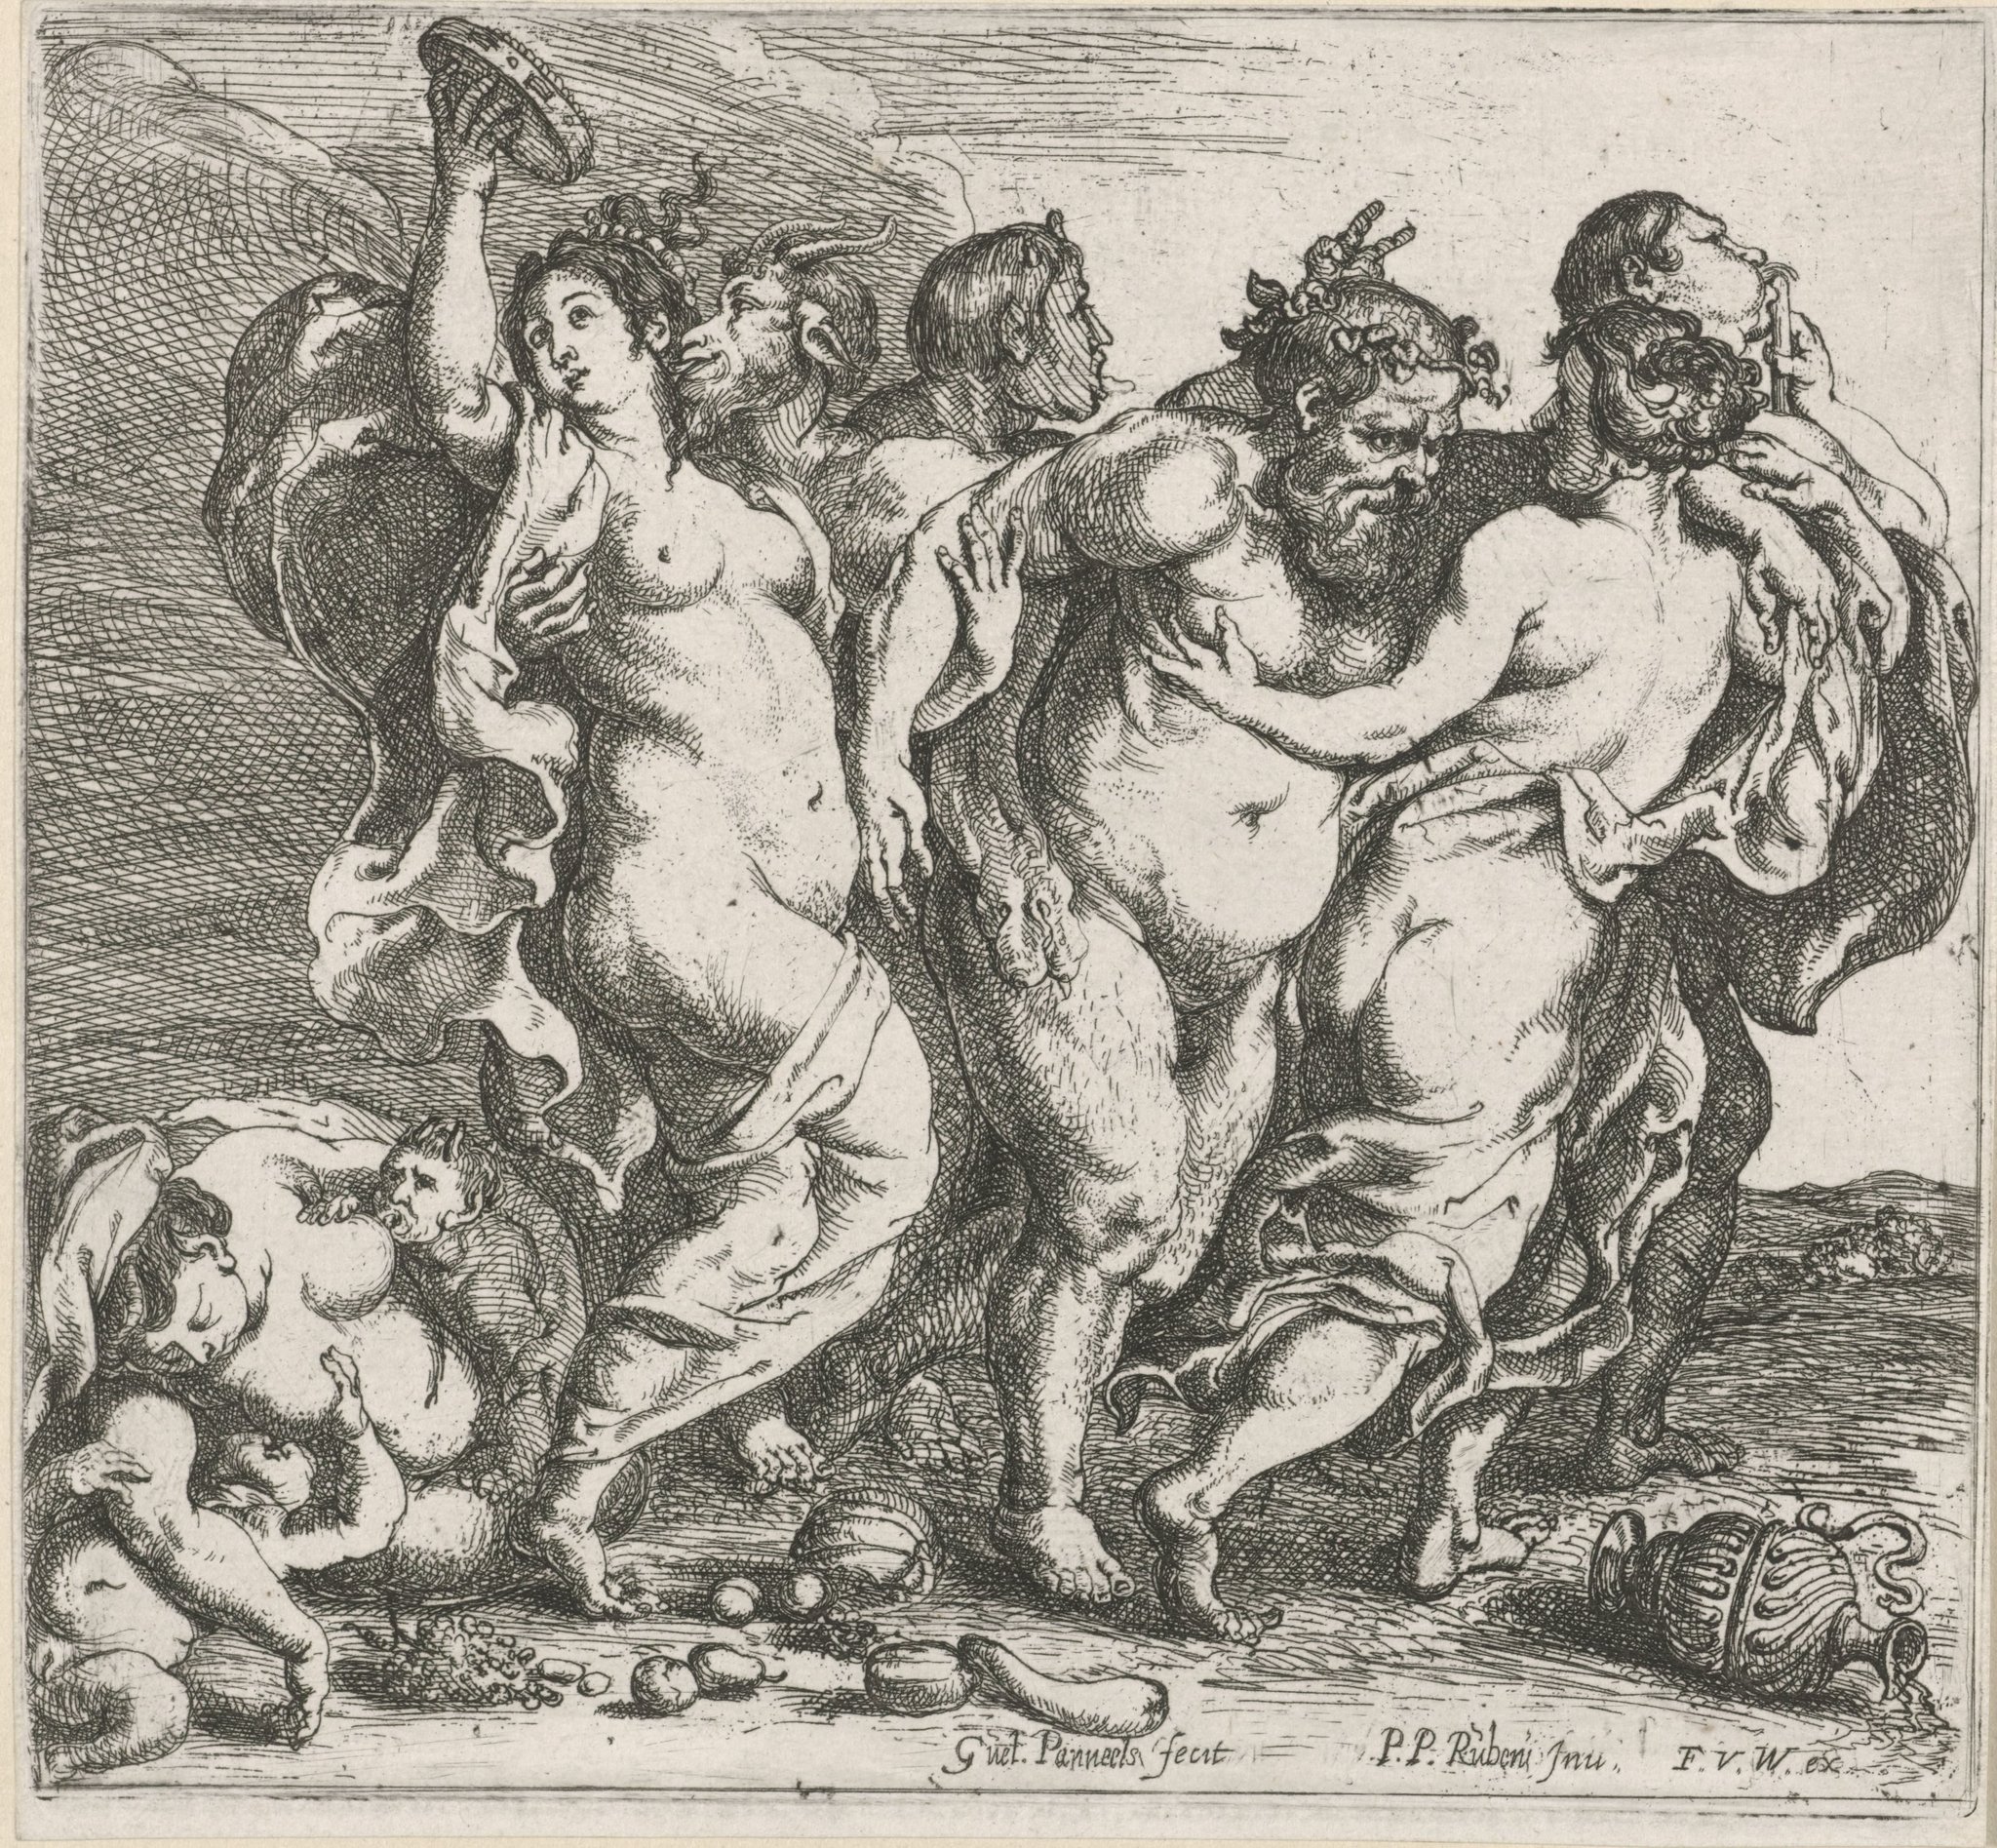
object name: print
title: Bacchanaal met Silenus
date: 1610-1634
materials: paper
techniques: engraving, etching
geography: antwerp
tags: (story of) silenus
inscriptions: collector's mark: Lugt 240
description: Silenus wordt voortgeduwd door saters en maenaden met cimbalen. Twee putti drinken uit de borsten van een naakte vrouw.